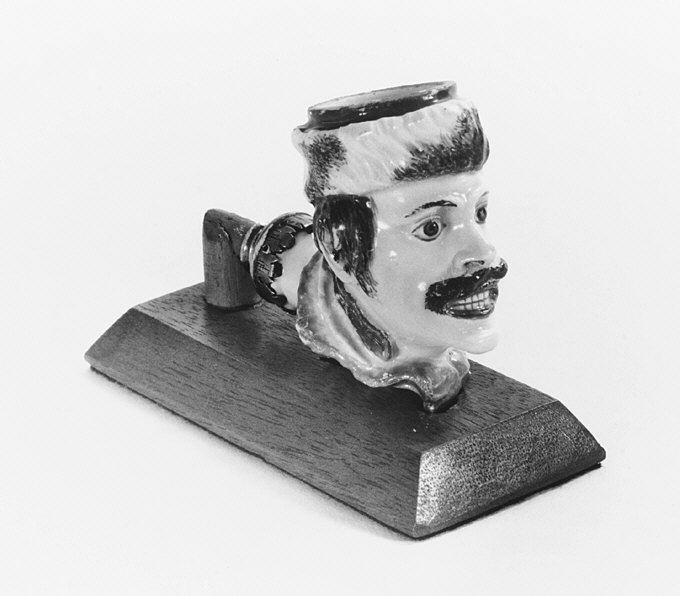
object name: pipe bowl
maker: meissen manufactory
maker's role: manufactory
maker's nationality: german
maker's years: 1710-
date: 1734-1766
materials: hard paste porcelain, silver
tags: heads,men